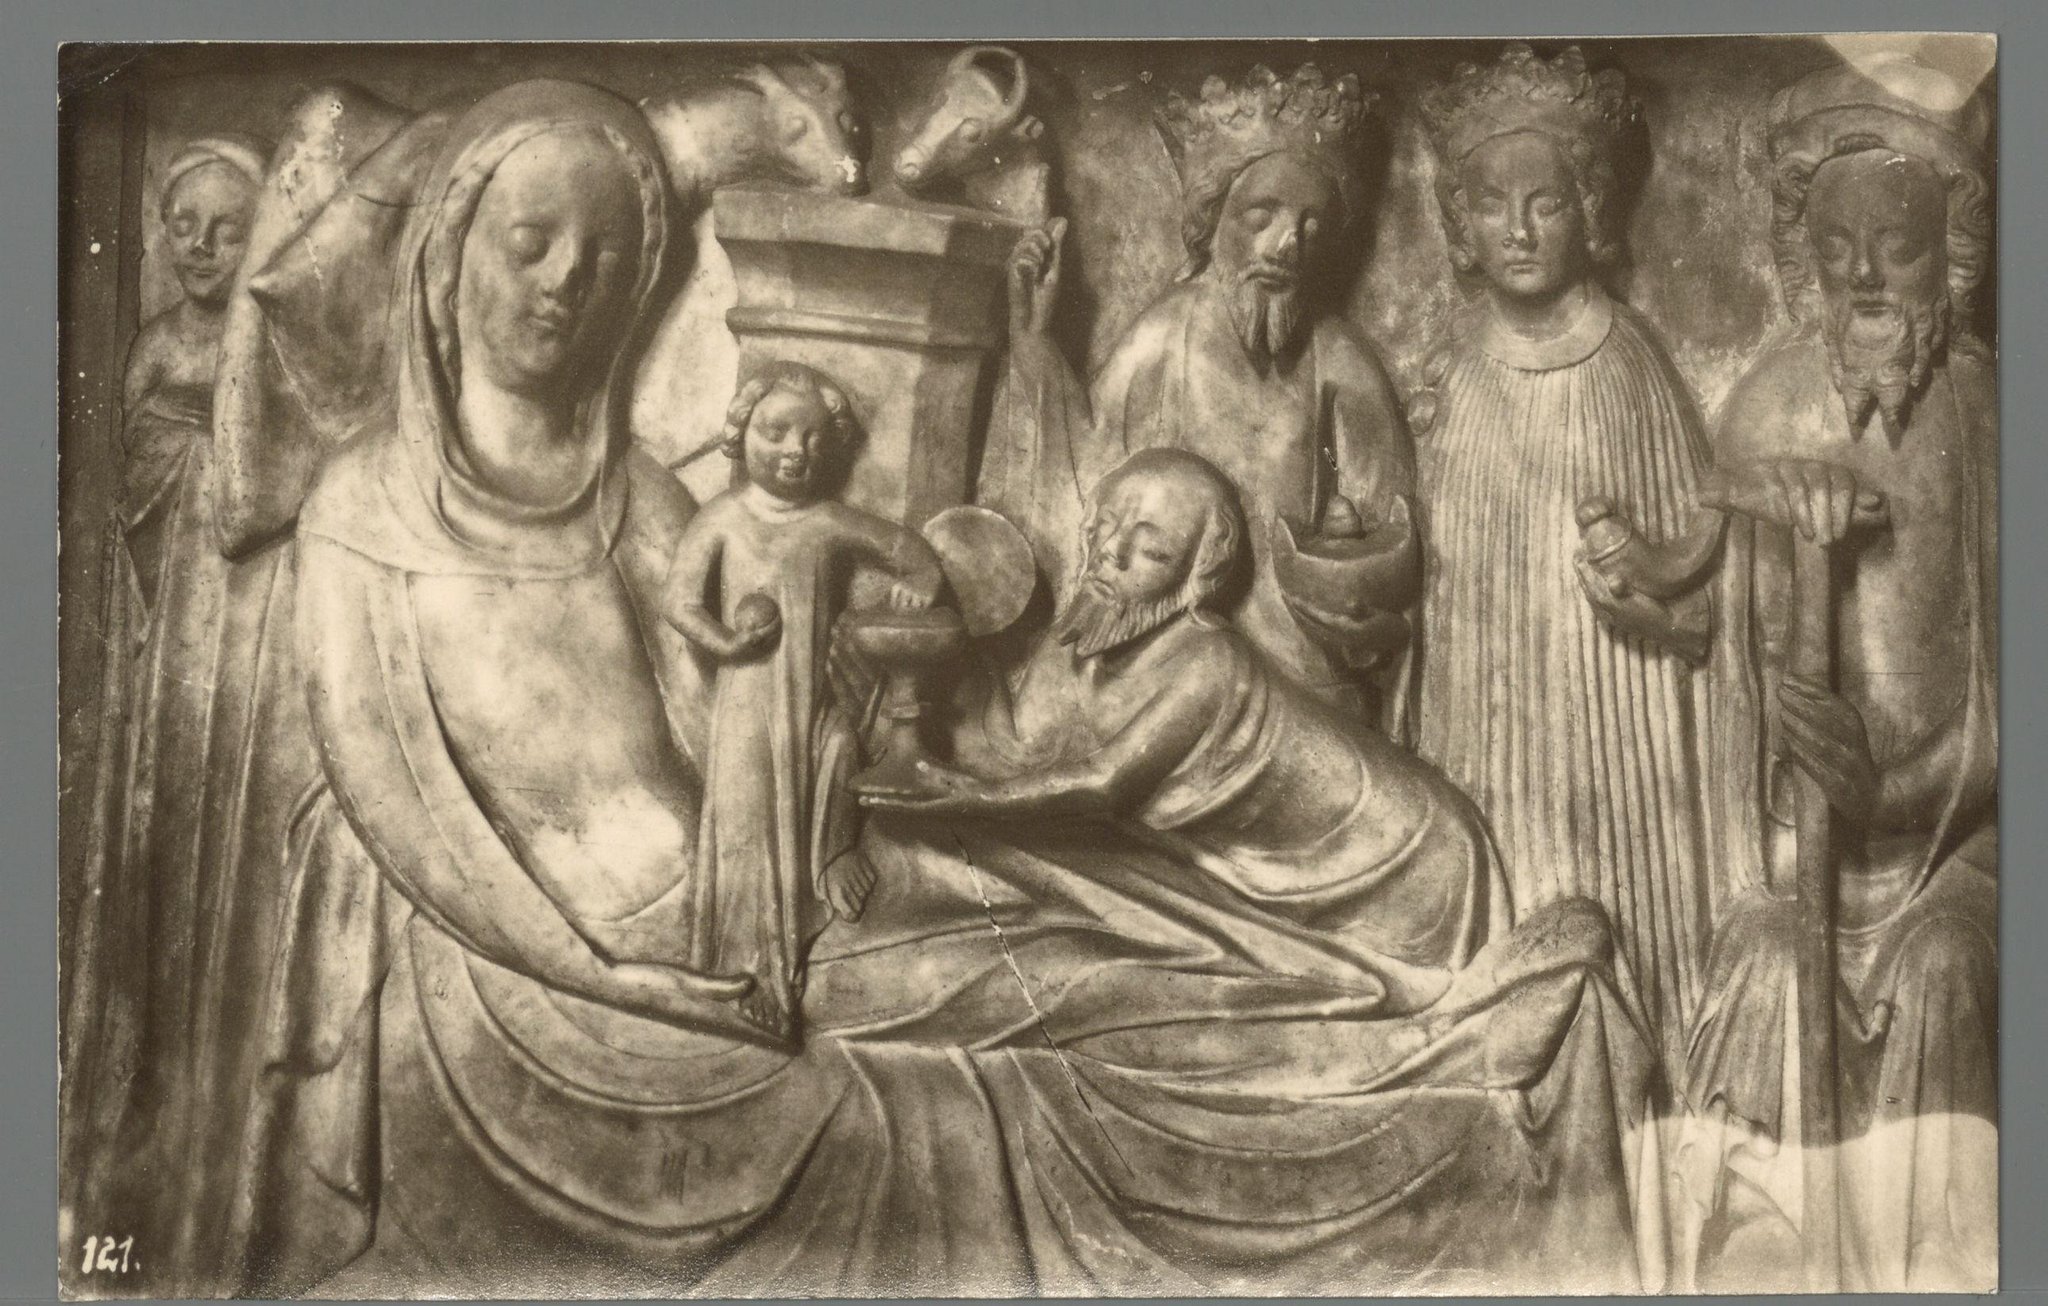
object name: ansichtkaart, prentbriefkaart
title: Reliëf in een kerk in Soest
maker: w. lange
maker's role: fotograaf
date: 1905-1930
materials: photographic support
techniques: gelatin silver print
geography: soest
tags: statues, paintings, etc. ~ objects of worship in roman religion, interior of church